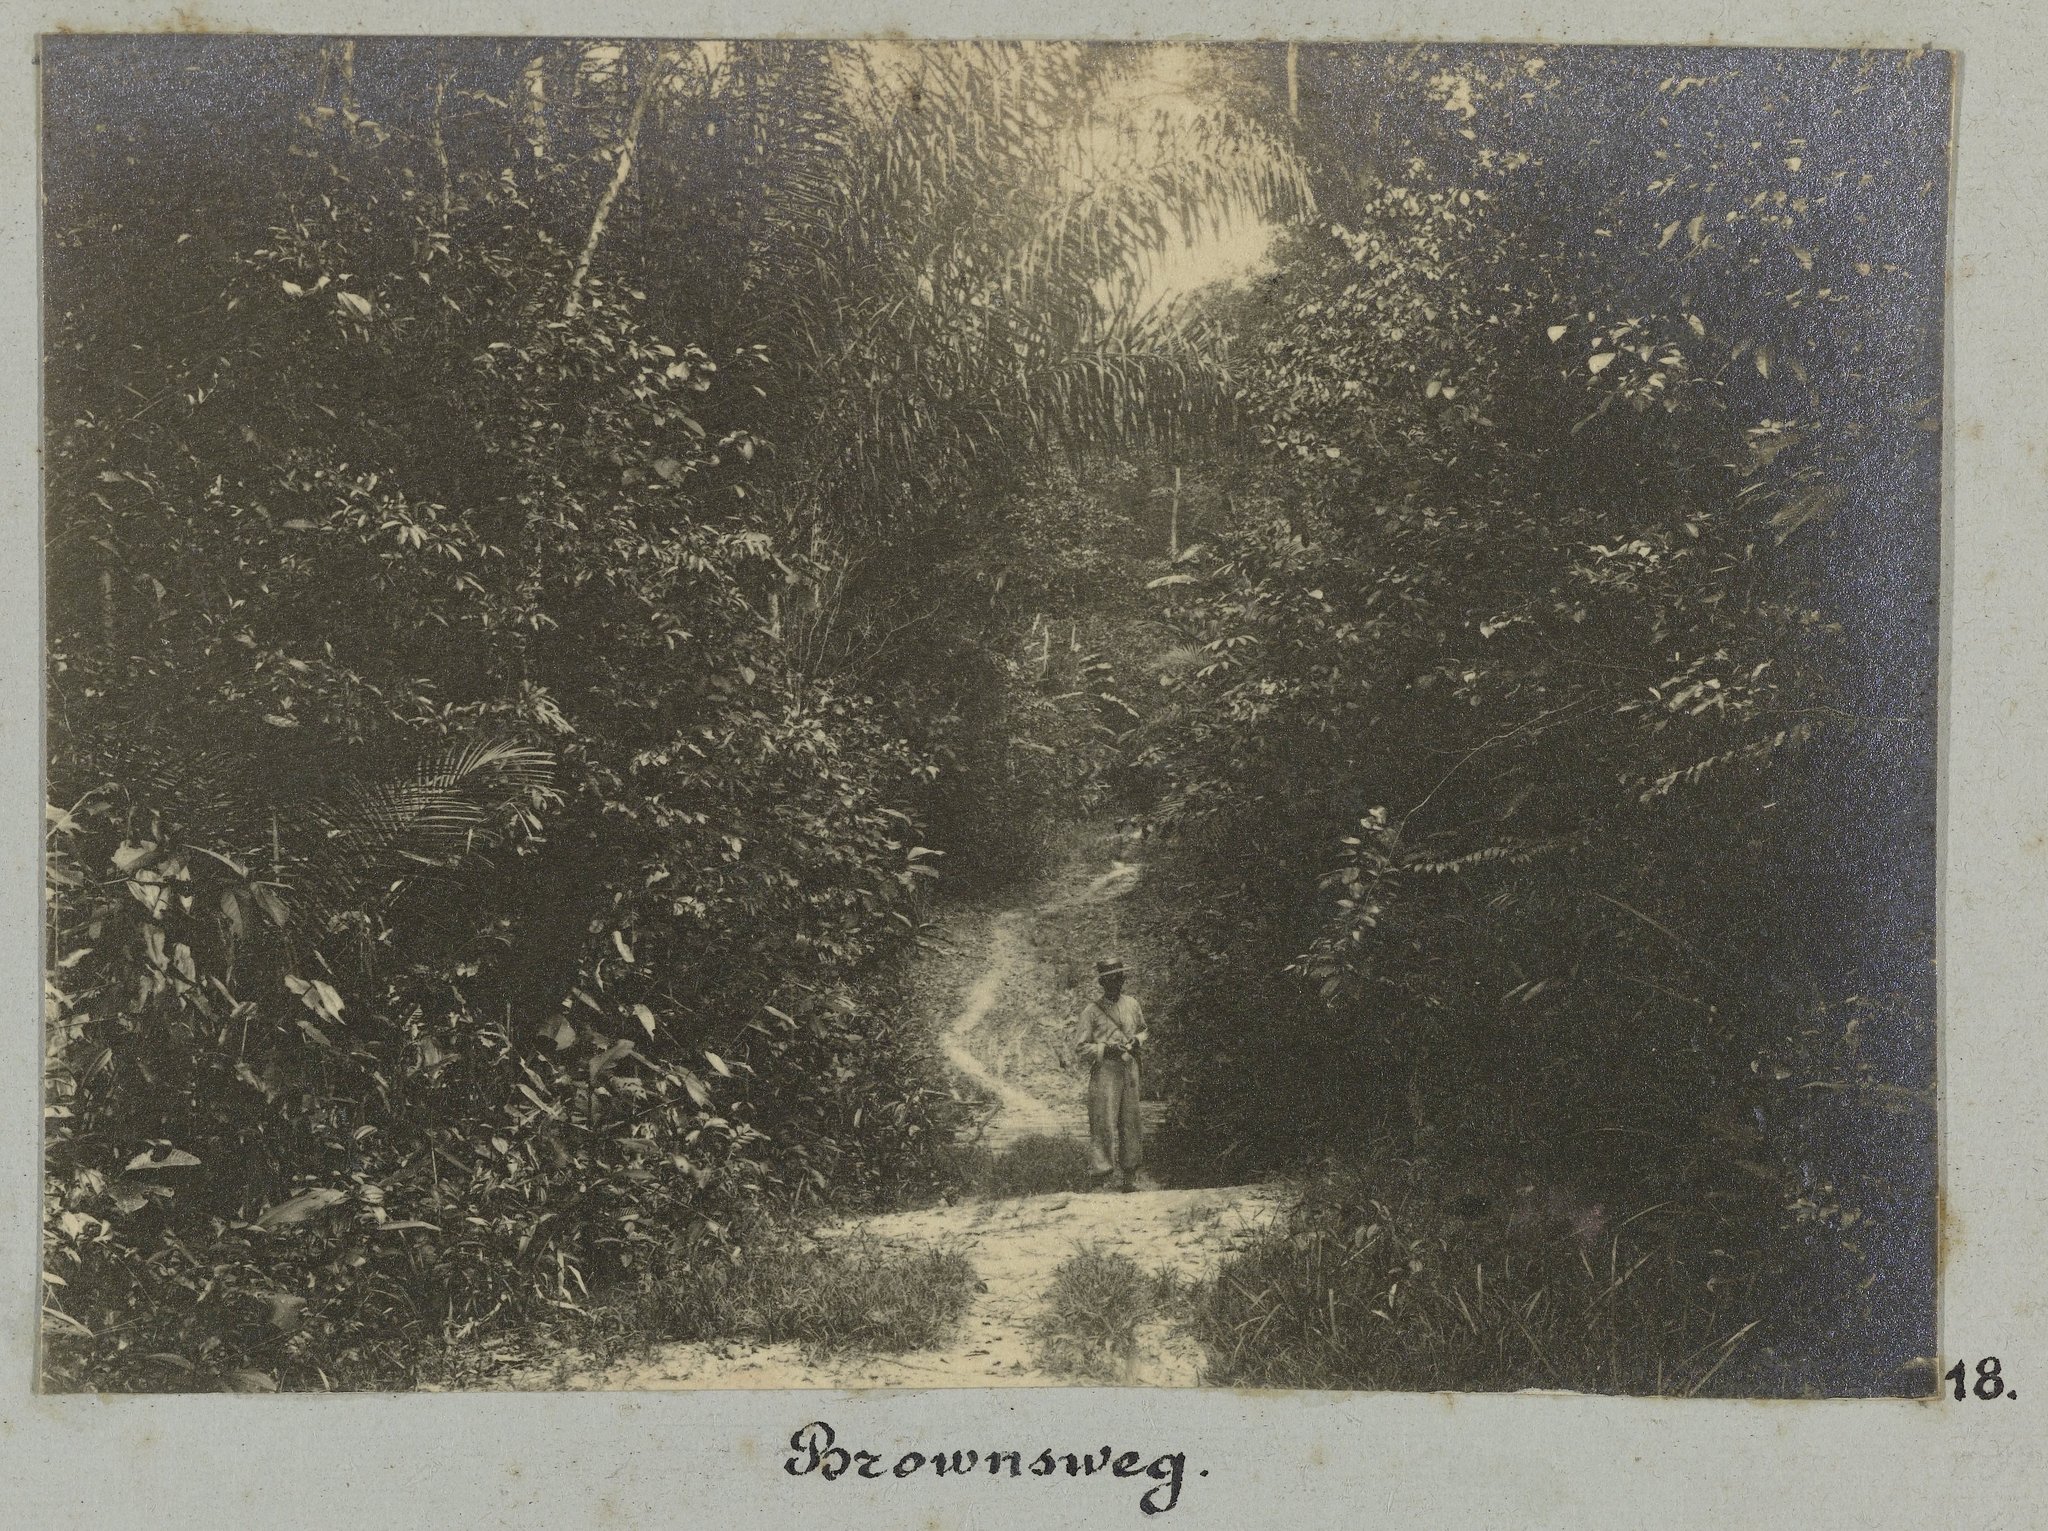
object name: photograph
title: Brownsweg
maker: hendrik doijer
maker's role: engineer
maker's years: 1863-1925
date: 1903-1910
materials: photographic support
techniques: gelatin silver print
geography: suriname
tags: suriname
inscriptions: inscription: ‘18. / Brownsweg.’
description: Een weg door het oerwoud bij de plaats Brownsweg, op de weg een staande man. Onderdeel van het fotoalbum Souvenir de Voyage (deel 1), over het leven van de familie Doijer in en rond de plantage Ma Retraite in Suriname in de jaren 1903-1910.